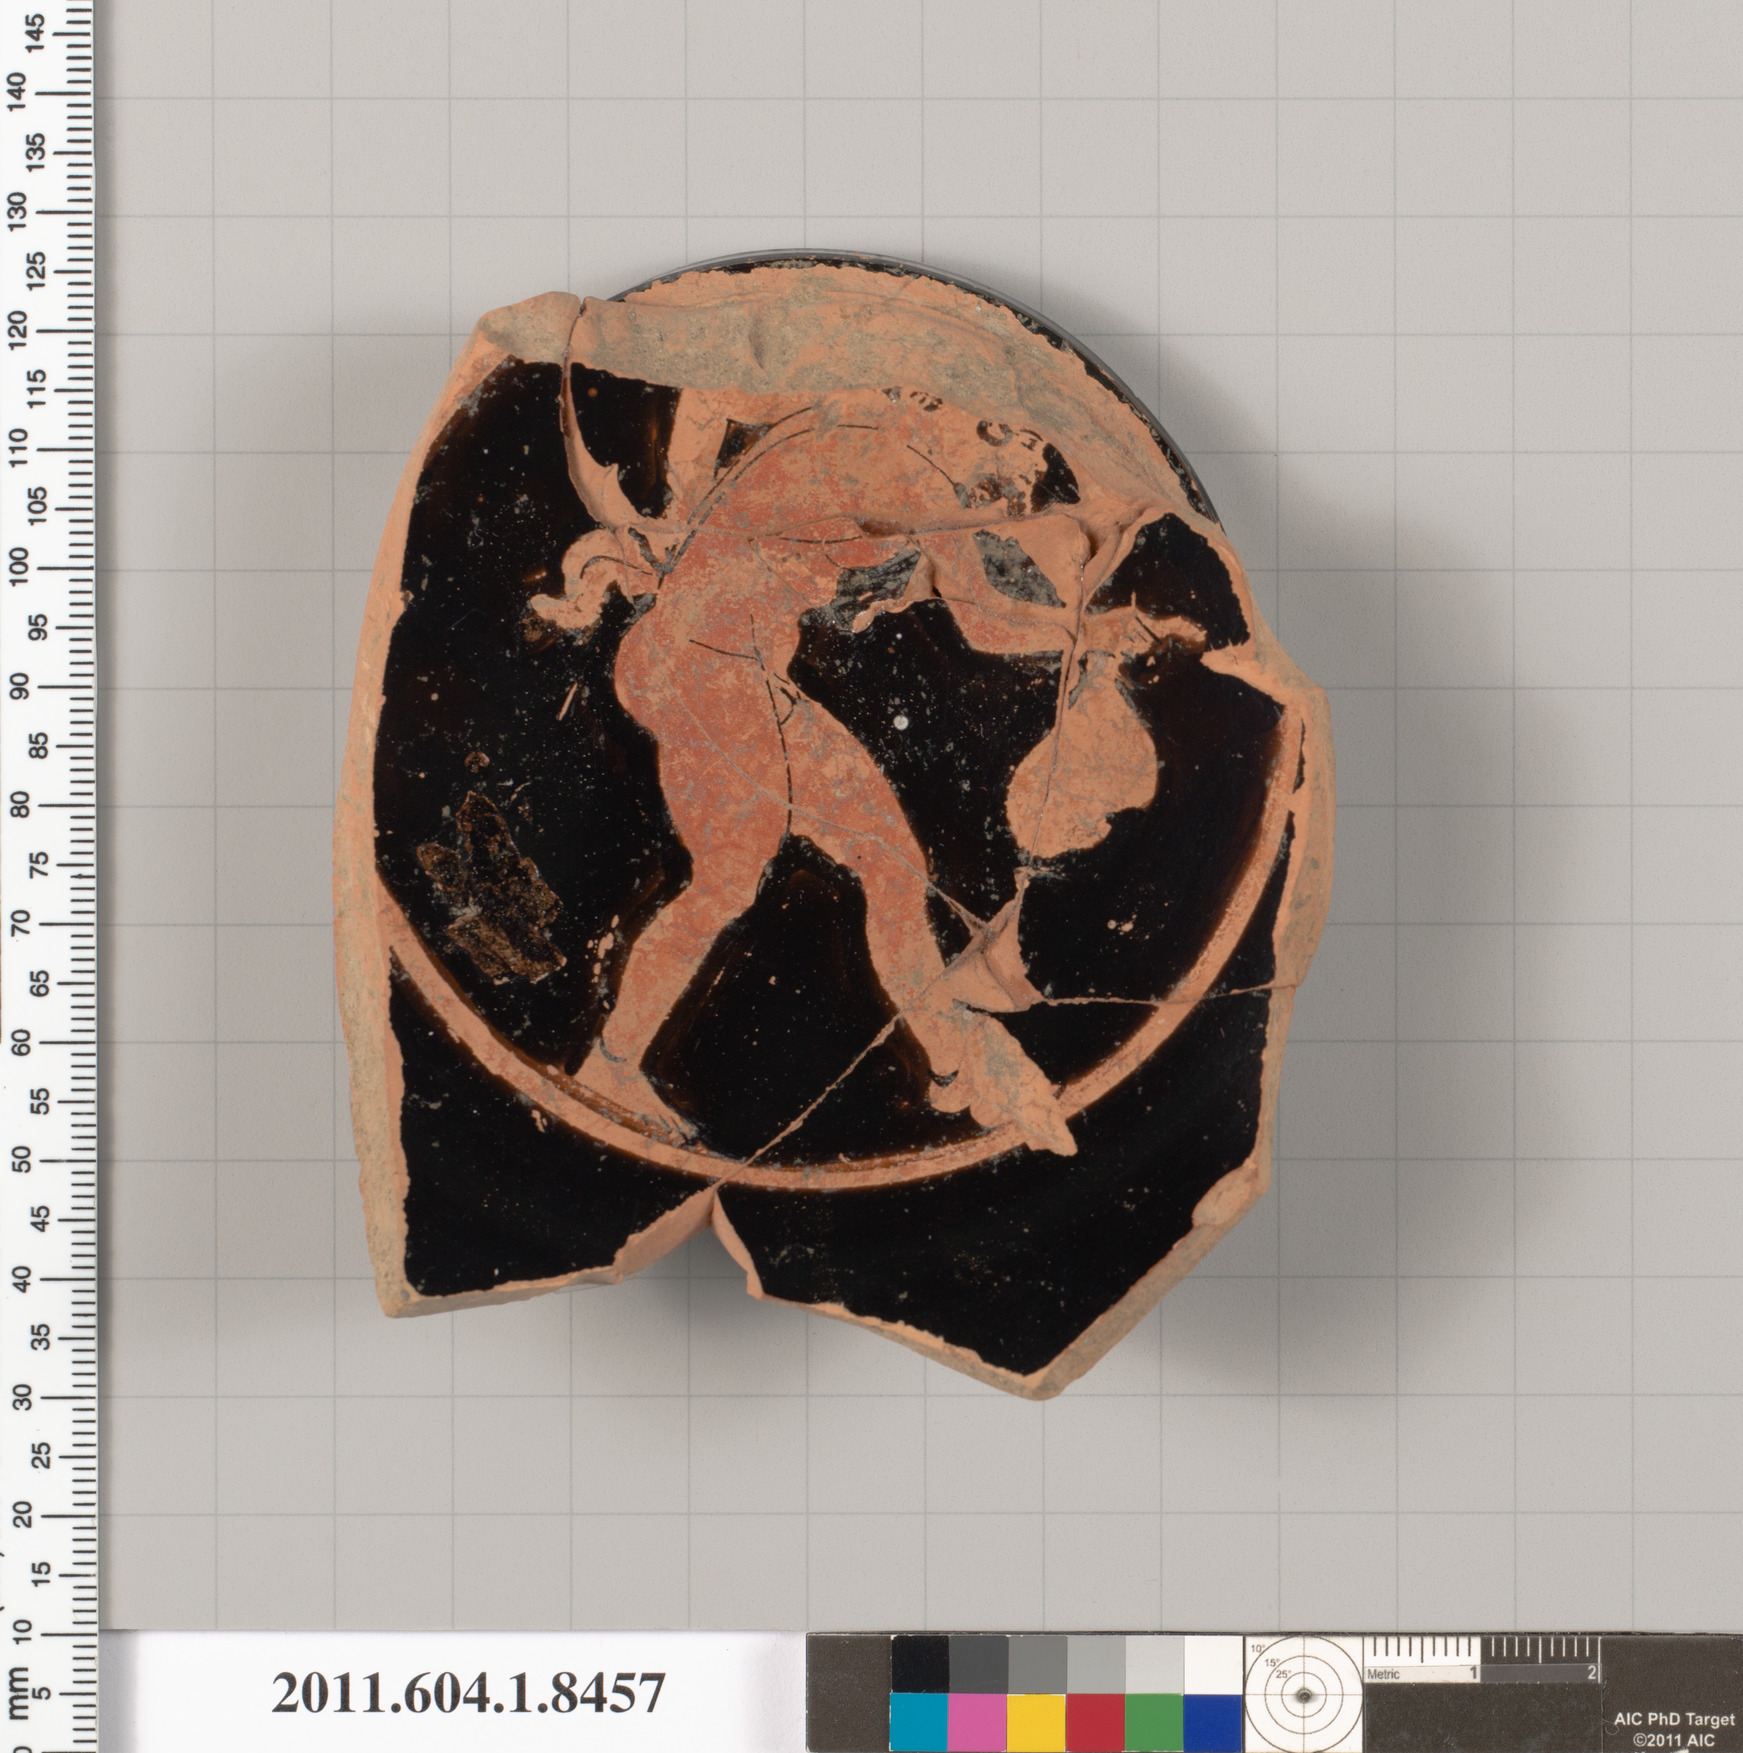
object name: kylix fragment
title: Terracotta fragment of a stemless kylix (drinking cup)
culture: greek, attic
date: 460-450 BCE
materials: terracotta